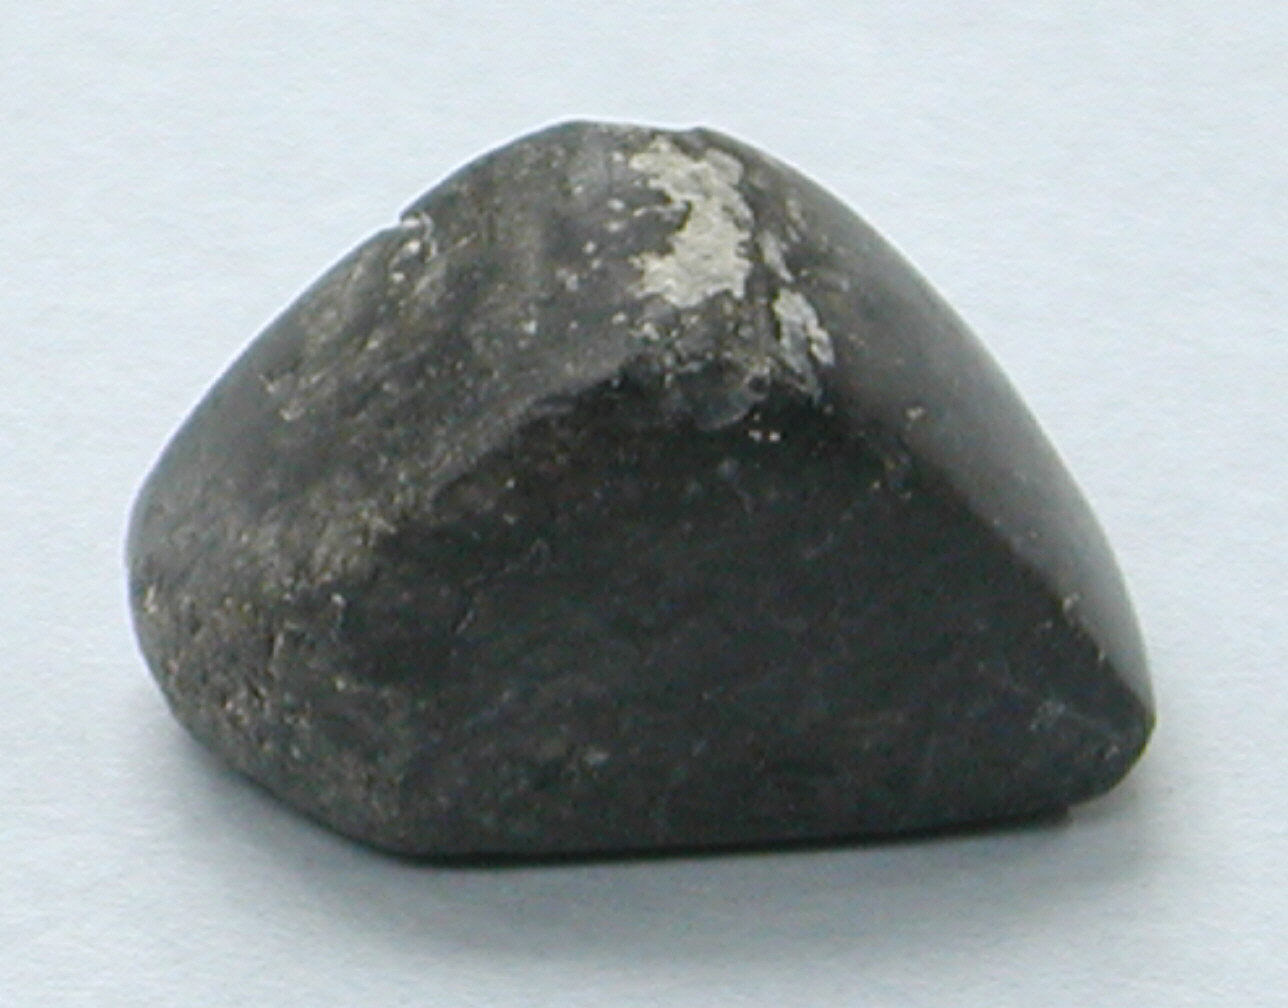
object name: ritual stone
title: Stone Pulidor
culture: mexican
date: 1501-1600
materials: stone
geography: mexico